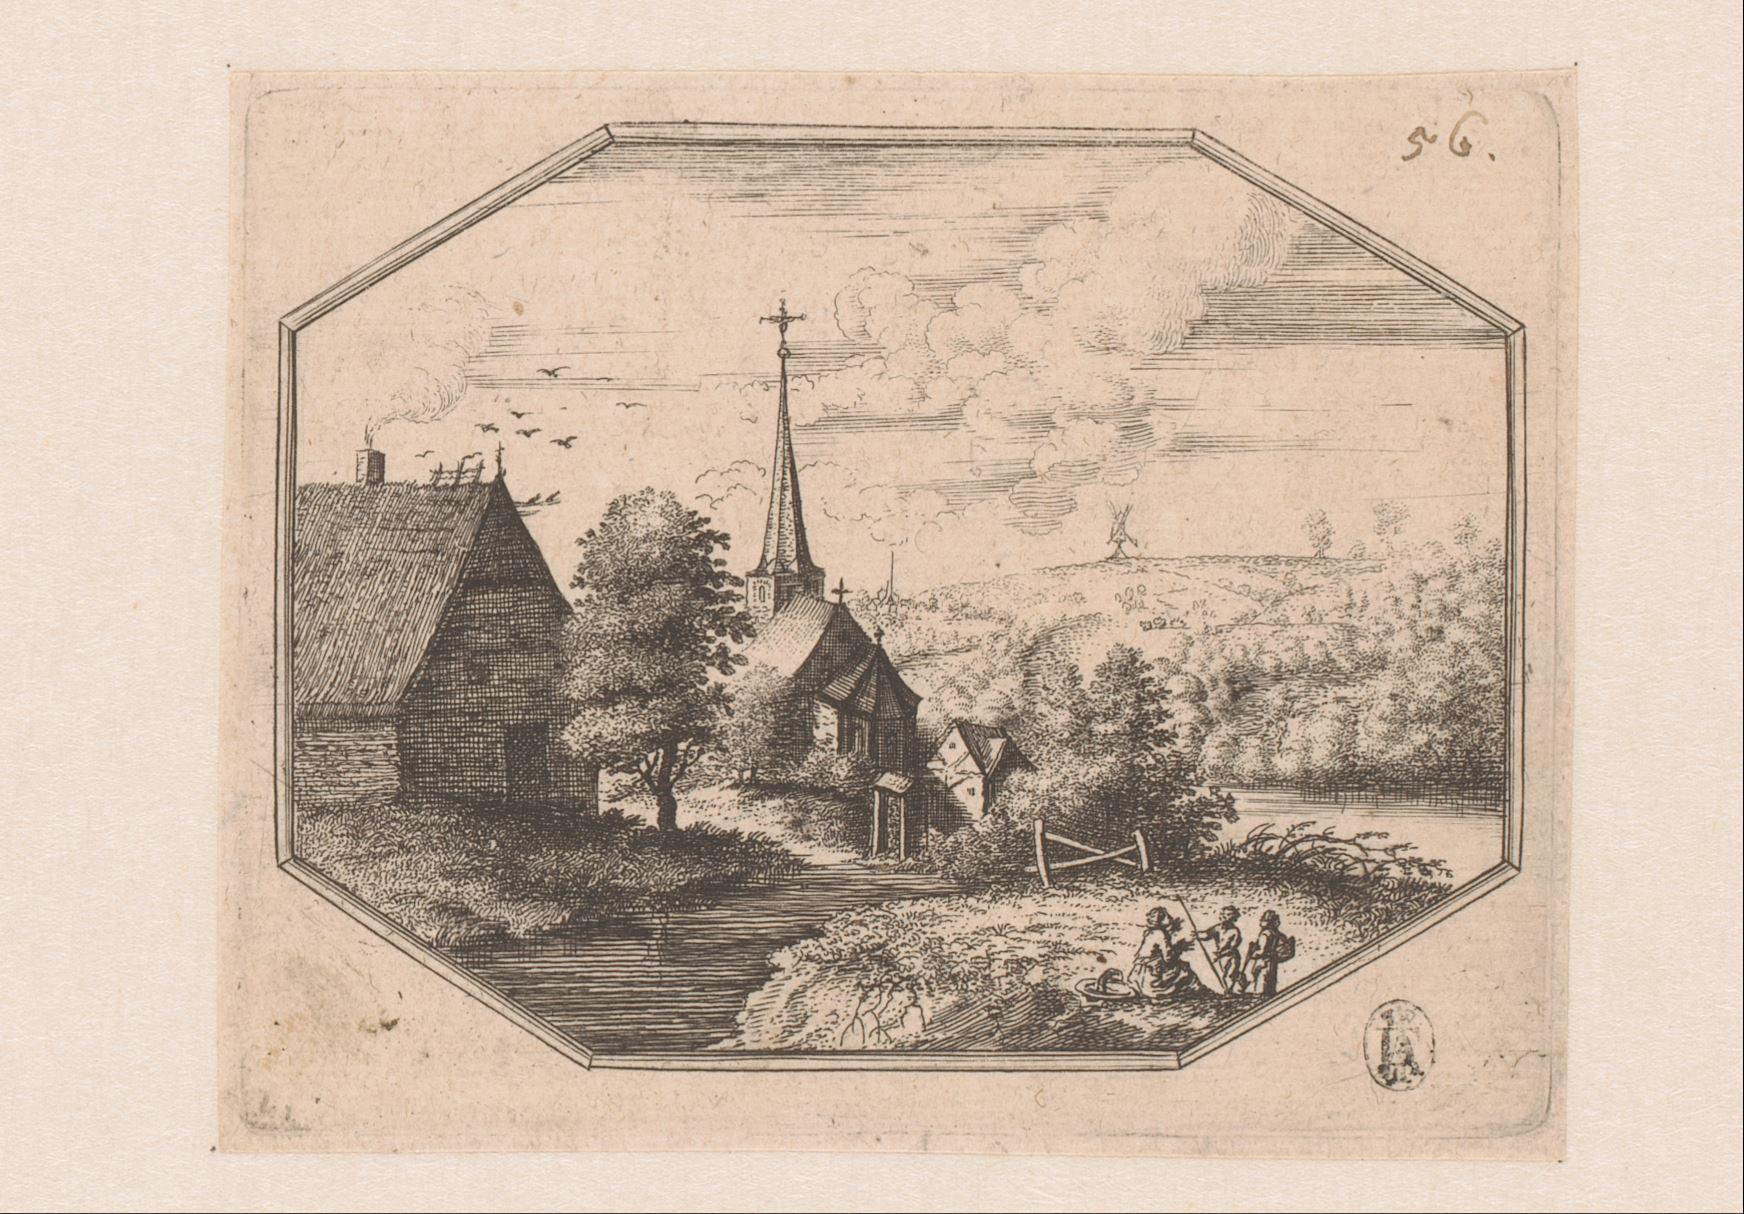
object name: print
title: Landschap met kerk en molen in de verte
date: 1610-1668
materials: paper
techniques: etching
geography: paris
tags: church (exterior), windmill in landscape, landscapes (+ landscape with figures, staffage)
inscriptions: collector's mark: Lugt 972, collector's mark: Lugt 2228, number: ‘56.’